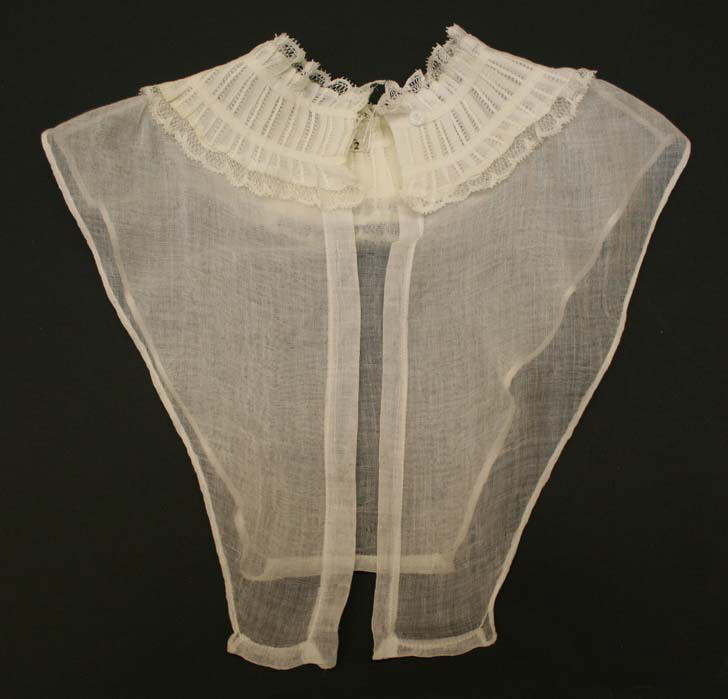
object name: collar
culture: european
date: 1818